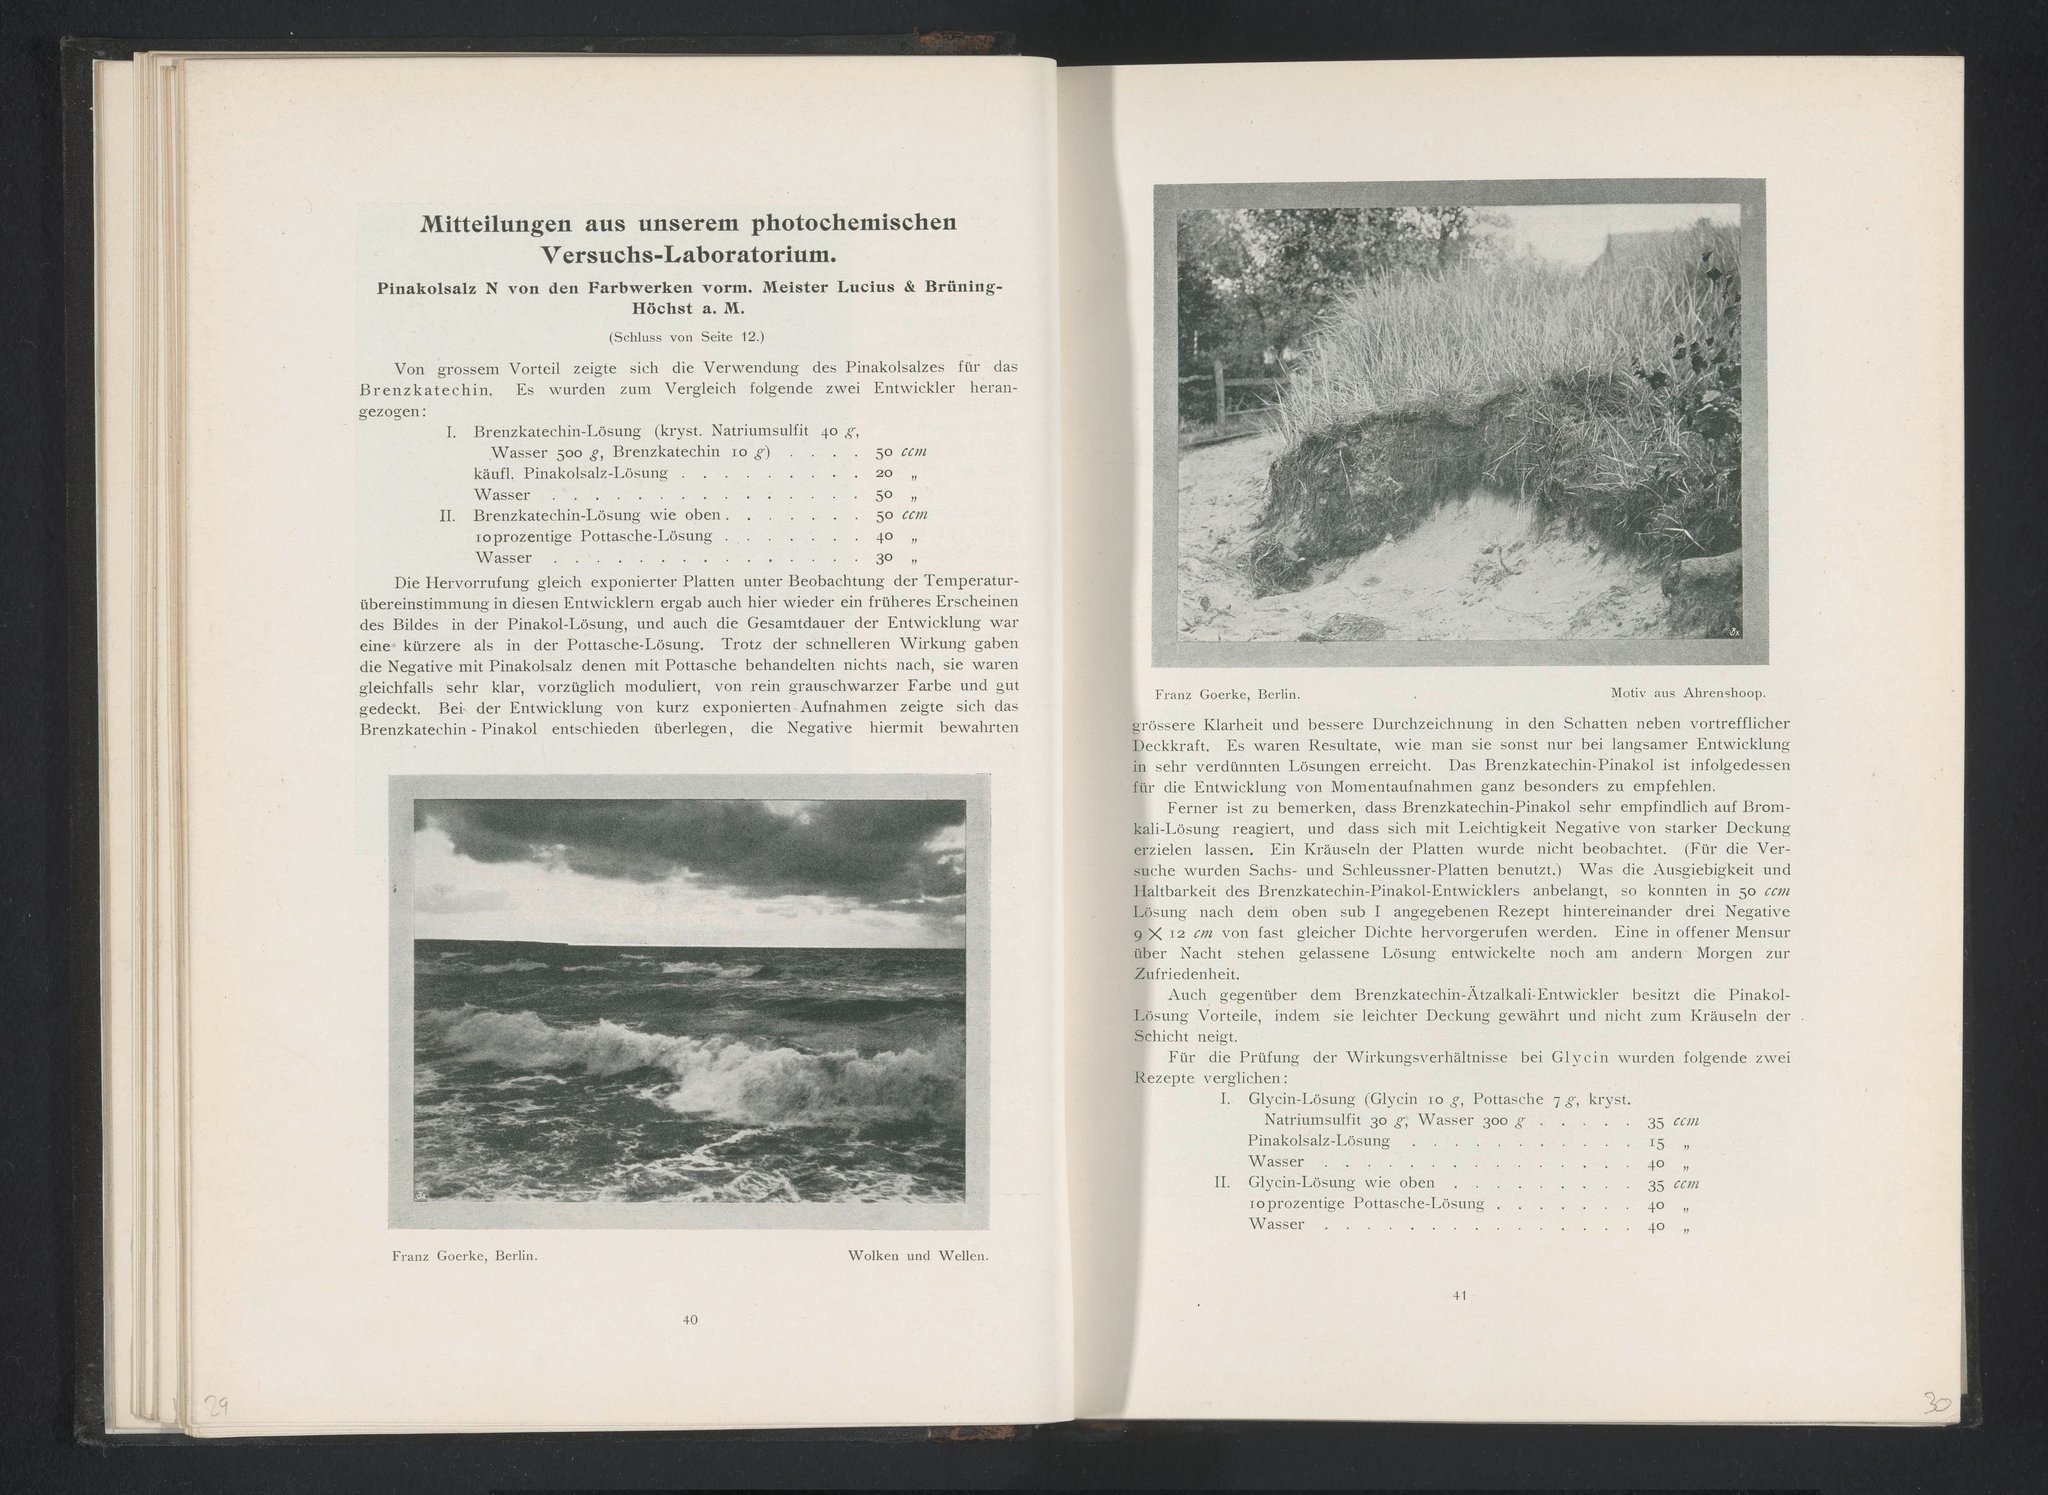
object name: page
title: Motiv aus Ahrenshoop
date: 1898-1903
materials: paper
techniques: autotype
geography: ostseebad ahrenshoop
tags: dunes (sea not visible); in the dunes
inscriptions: monogram: ‘BX’, inscription: ‘Berlin’